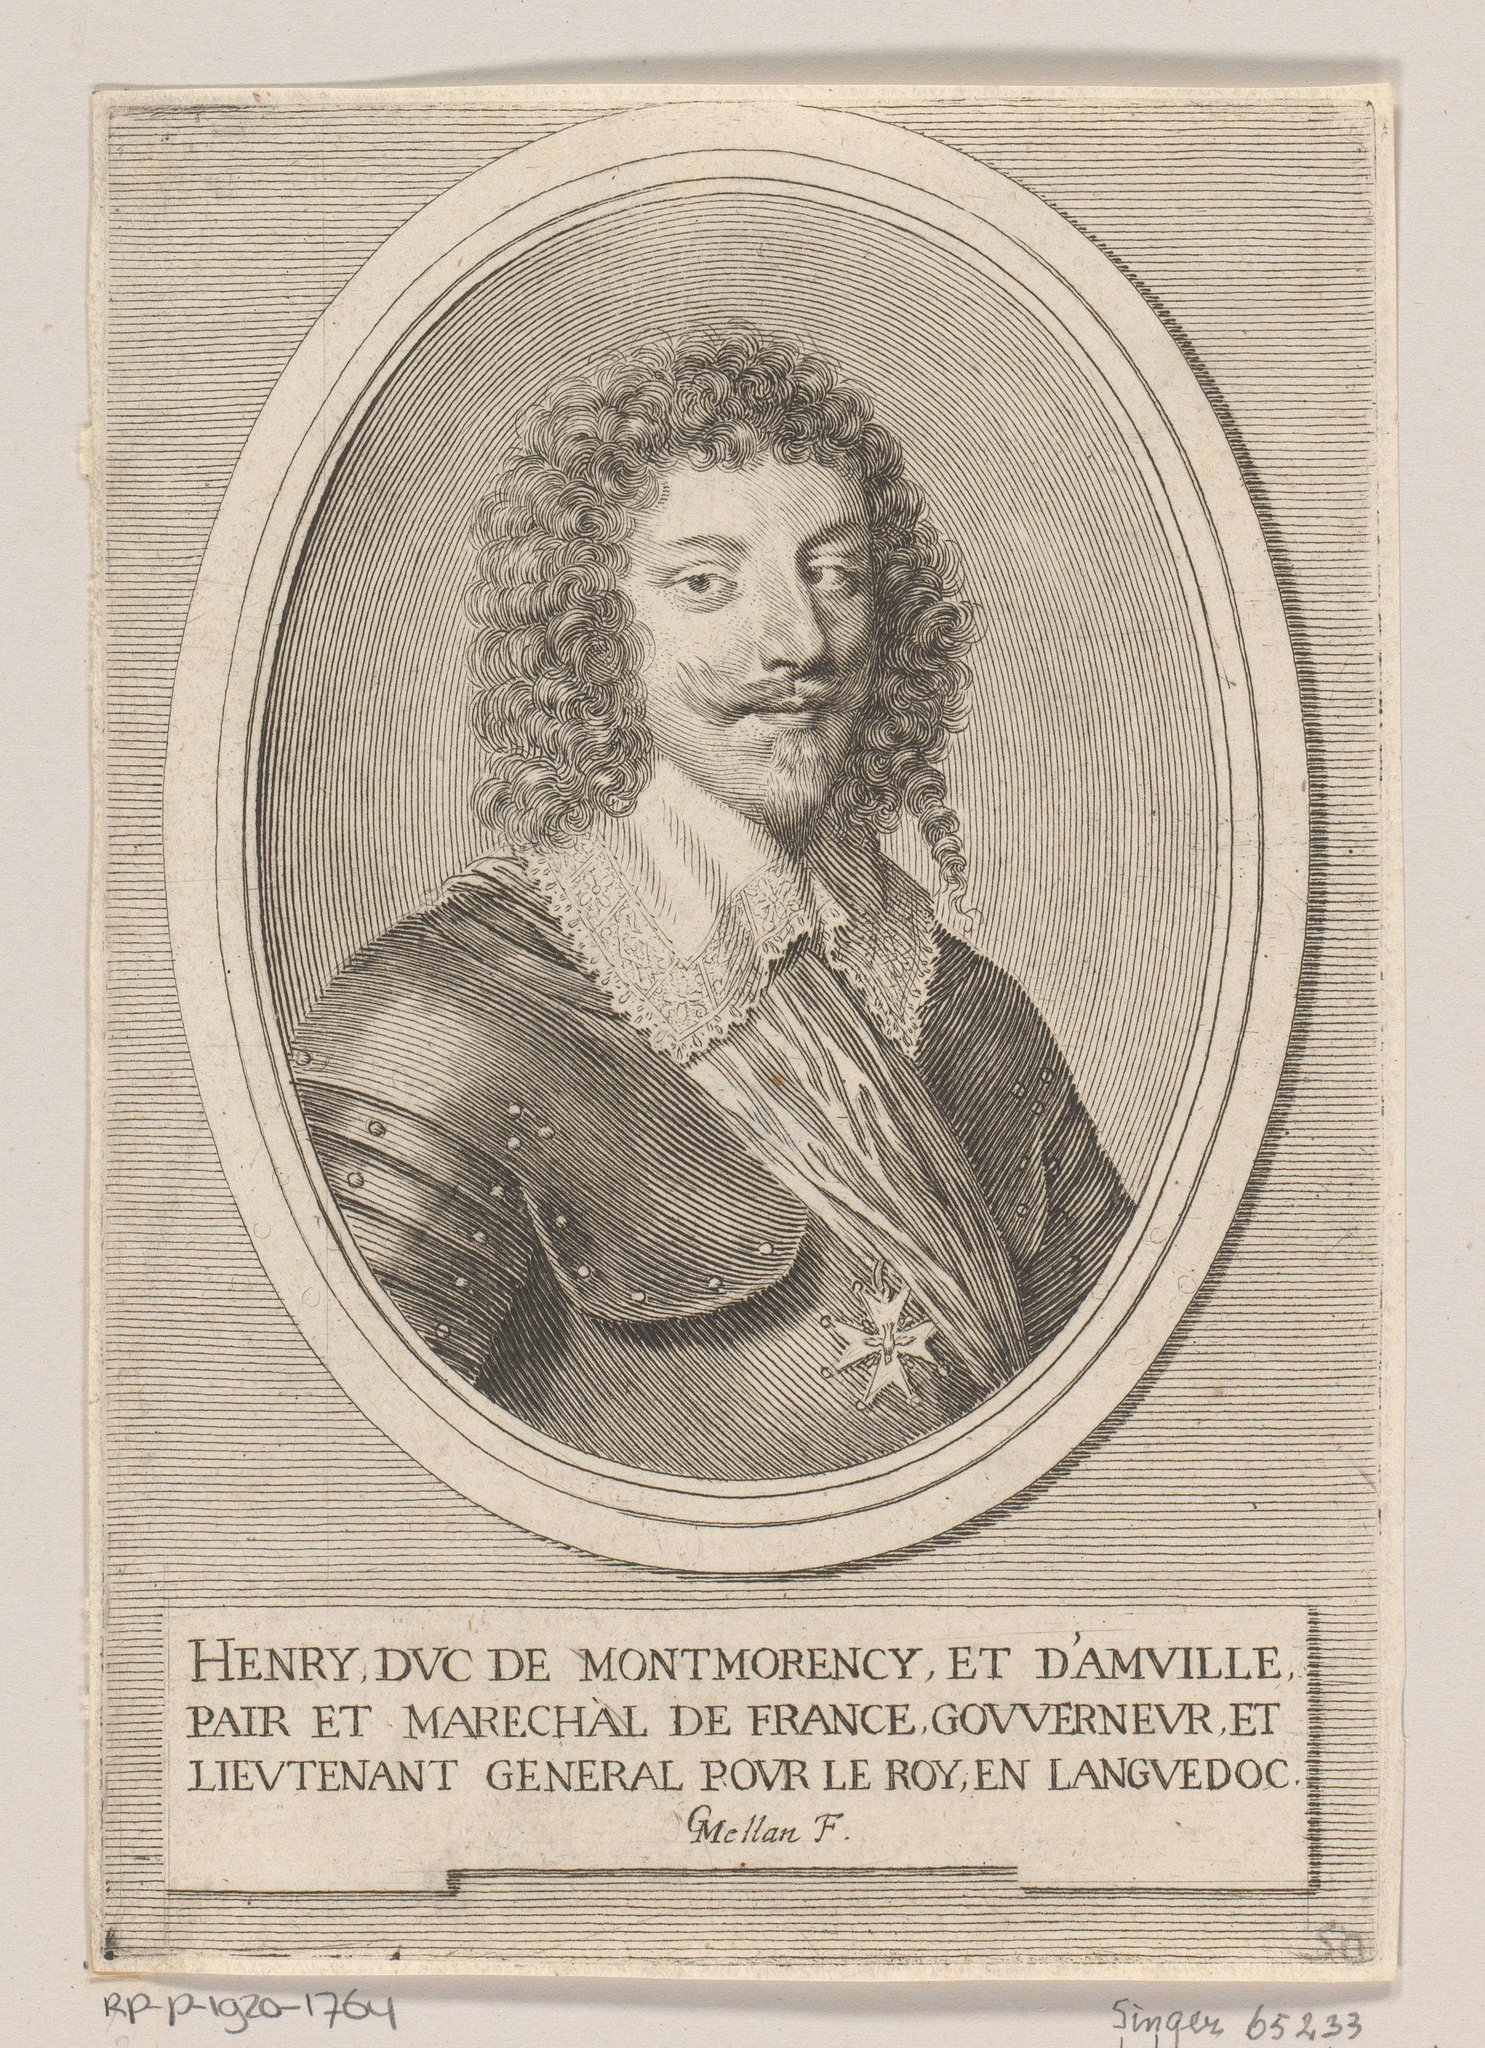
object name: print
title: Henry Duc de Montmorency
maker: claude mellan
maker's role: draughtsman, print maker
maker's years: 1598-1688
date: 1636-1688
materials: paper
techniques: engraving, etching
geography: paris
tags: chantilly, ranks in the army, historical persons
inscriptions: collector's mark: Lugt 2228